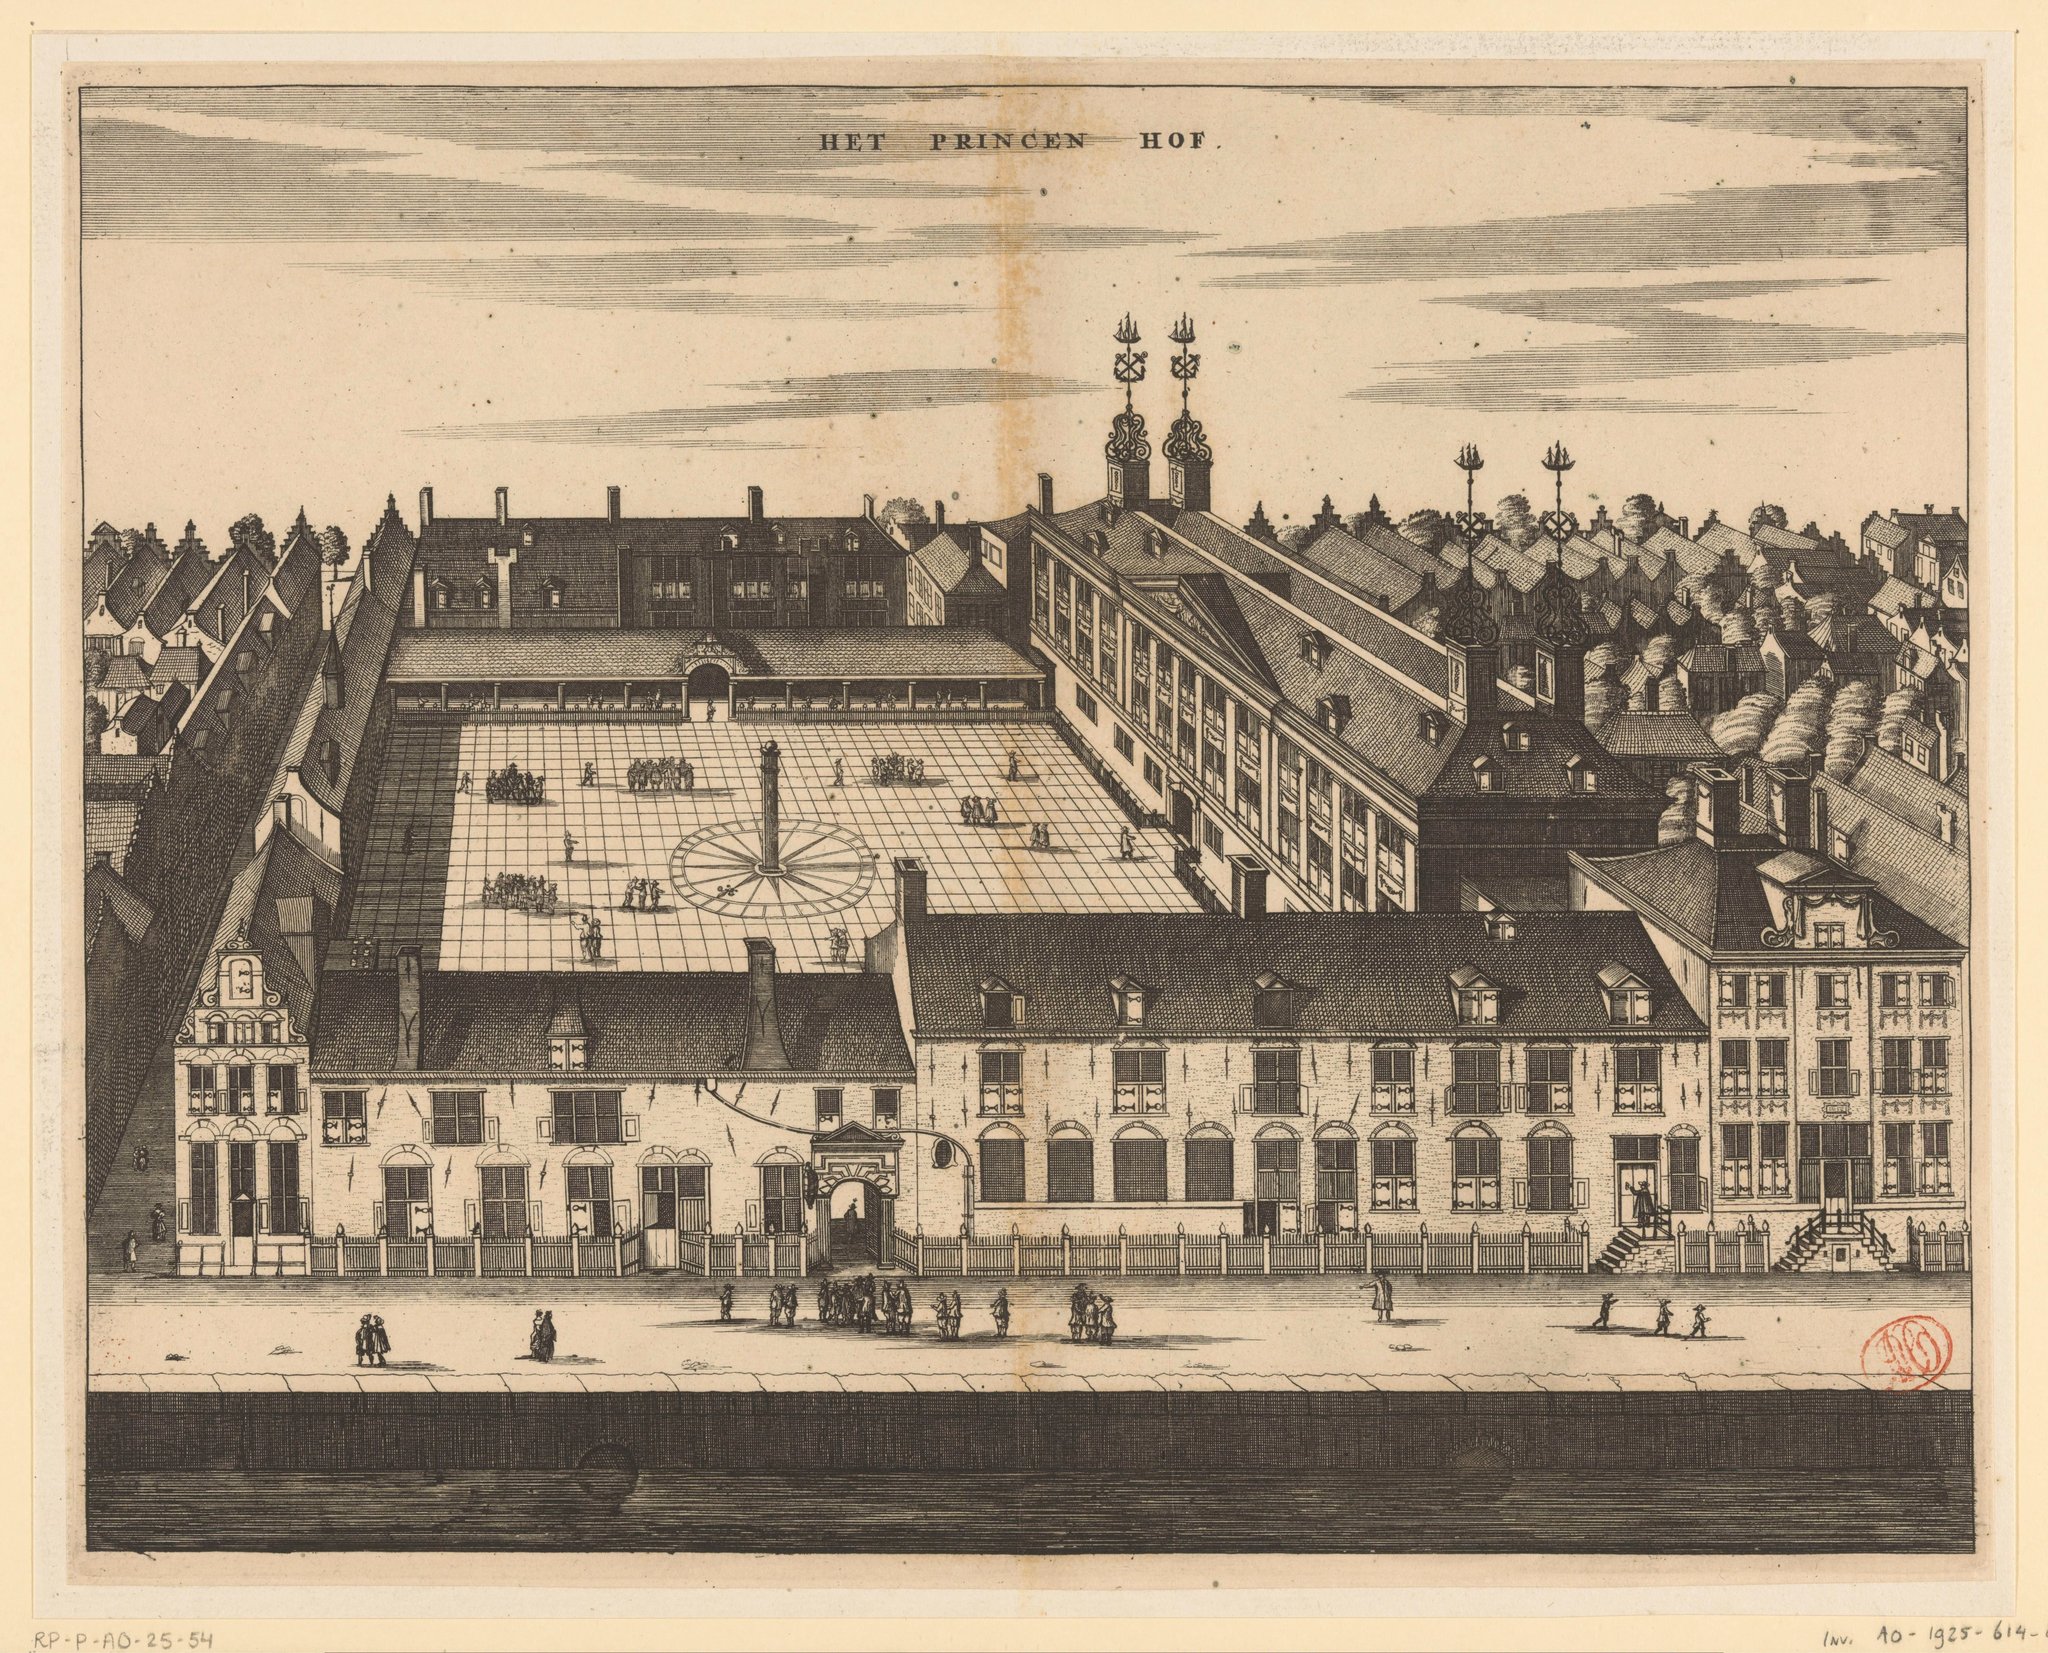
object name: book illustration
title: Gezicht op het Prinsenhof te Amsterdam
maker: Anonymous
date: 1693-1694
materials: paper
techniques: engraving, etching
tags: courtyard, exterior ~ representation of a building, street (+ city(-scape) with figures, staffage)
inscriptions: collector's mark: Lugt 195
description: Huidige staat van prent ook gebruikt in: Commelin, Caspar. Beschryvinge van Amsterdam, desselfs eerste oorspronk uyt den Huyse (…). 2 delen. Amsterdam: Abraham Wolfgang, Gillis Janssonius van Waesberge, Johannes Janssonius van Waesberge II, weduwe Dirk Boom I, Hendrick Boom en Rembertus Goethals, 1693. En in: Commelin, Caspar. Beschryvinge van Amsterdam, zynde een naukeurige verhandelinge van desselfs eerste oorspronk uyt (…). 2 delen. Amsterdam: weduwe Aart Dircksz Oossaan, 1694. Latere staat ook gebruikt in: Commelin, Caspar. Beschryvinge van Amsterdam, zynde een naukeurige verhandelinge van desselfs eerste oorspronk uyt (…). 2 delen. 2e druk. Amsterdam: Andries van Damme, Johannes Ratelband, weduwe A. van Aaltwyk en Hermanus Uytwerf, 1726.